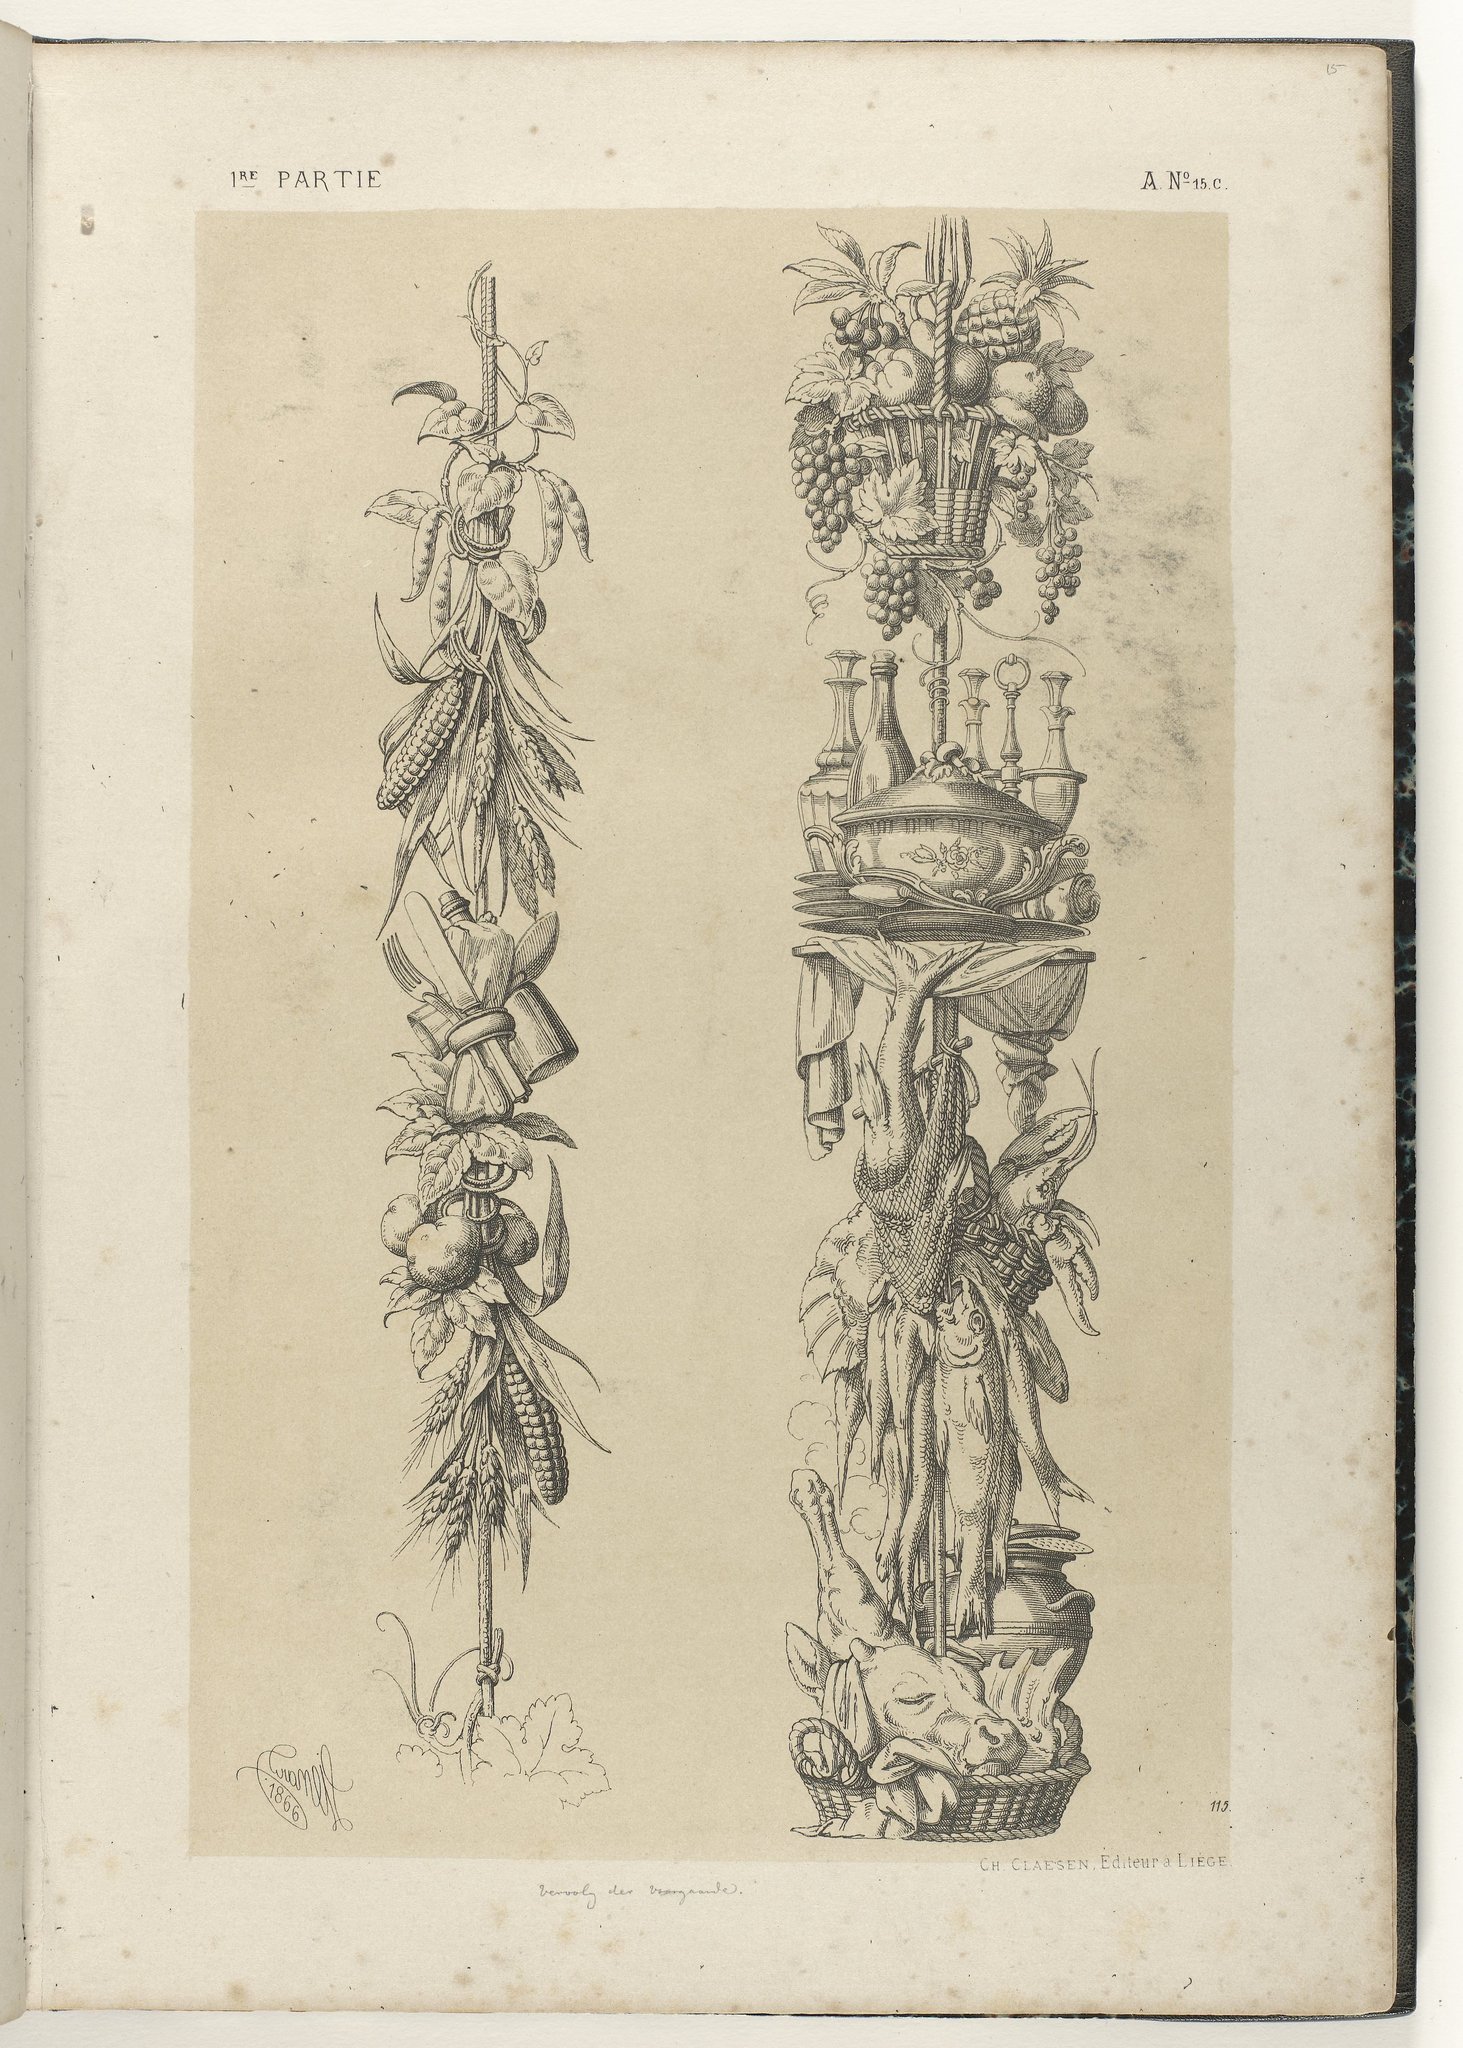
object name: print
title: Twee trofeeën van groente, fruit, vlees, vis en keukengerei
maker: michel liénard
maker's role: print maker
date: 1866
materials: paper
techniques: tone lithography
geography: liège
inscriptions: annotation: ‘Vervolg der voorgaande.’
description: Linksboven: 1re partie, rechtsboven: A. N° 15.C., rechtsonder: 115.